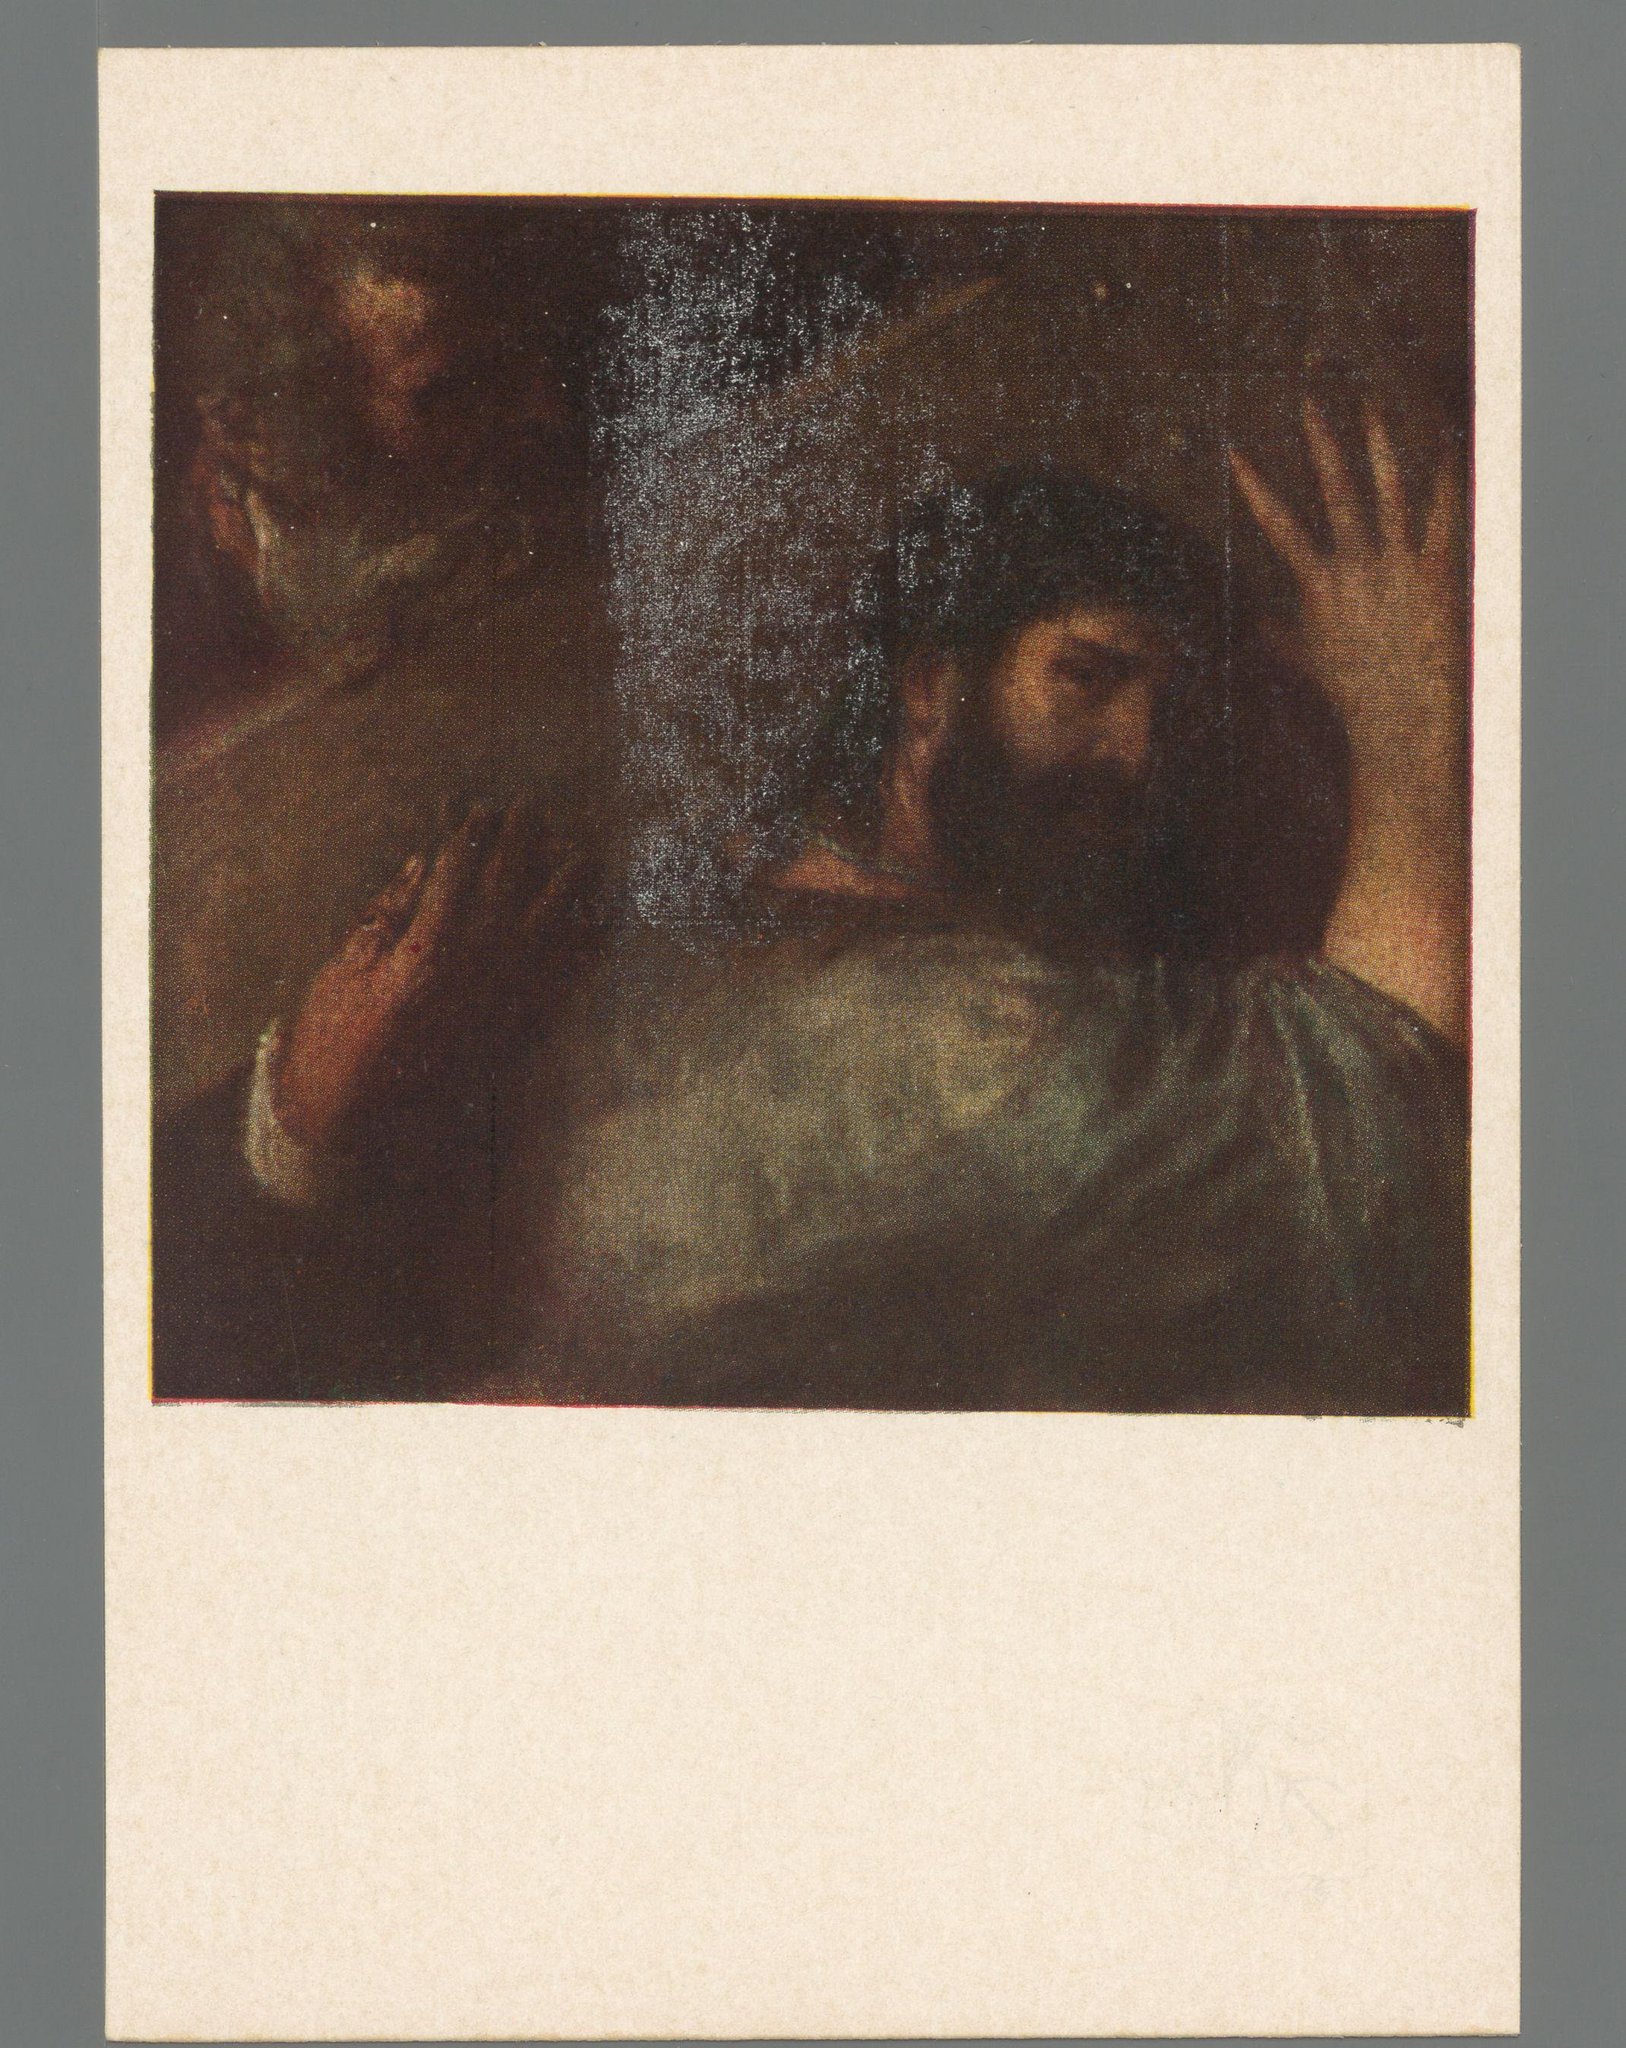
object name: reproduction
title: Le Titien (Tiziano Vecellio). Le Portement de croix / Titian Vecelli. Carrying the Cross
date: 1956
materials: cardboard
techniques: color autotype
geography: moscow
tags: permanent exhibition, museum, picture, painting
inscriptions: date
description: De titel op object staat ook in het Russisch.